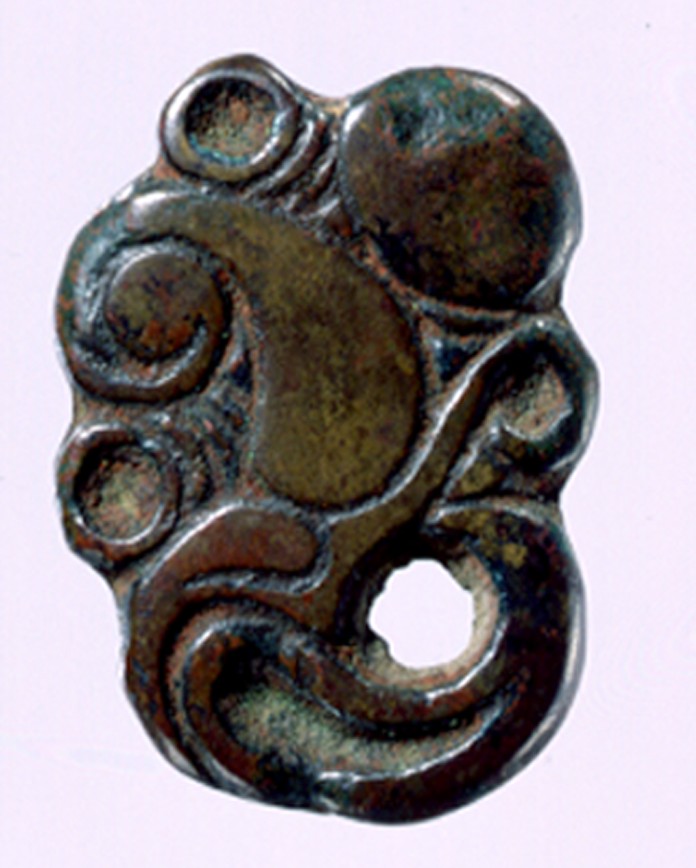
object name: garment plaque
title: Garment Plaque in the Shape of a Raptor's Head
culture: chinese or mongolian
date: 500-401 BCE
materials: bronze